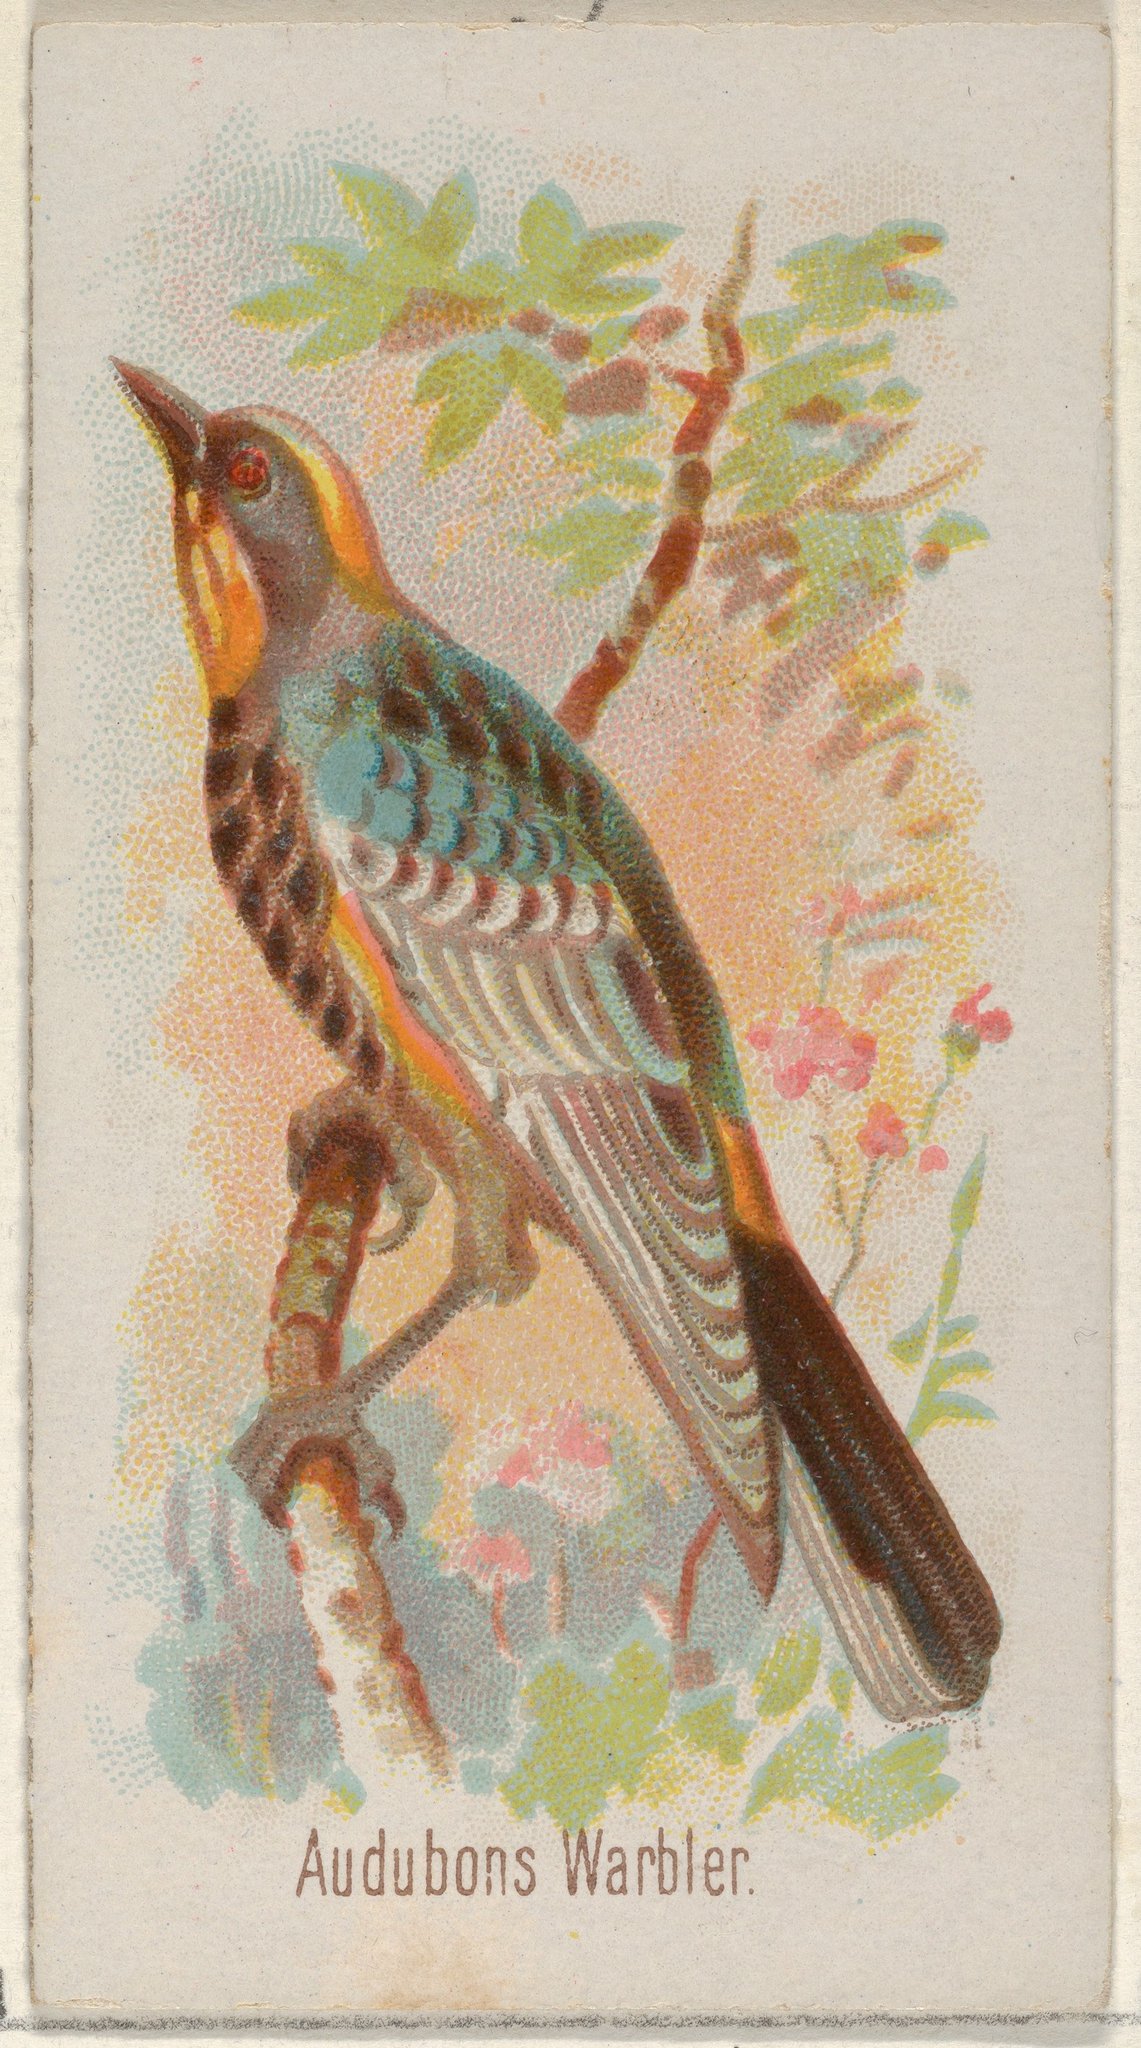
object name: print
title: Audobons Warbler, from the Song Birds of the World series (N23) for Allen & Ginter Cigarettes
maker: allen & ginter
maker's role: publisher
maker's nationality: american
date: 1890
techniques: color lithograph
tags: birds